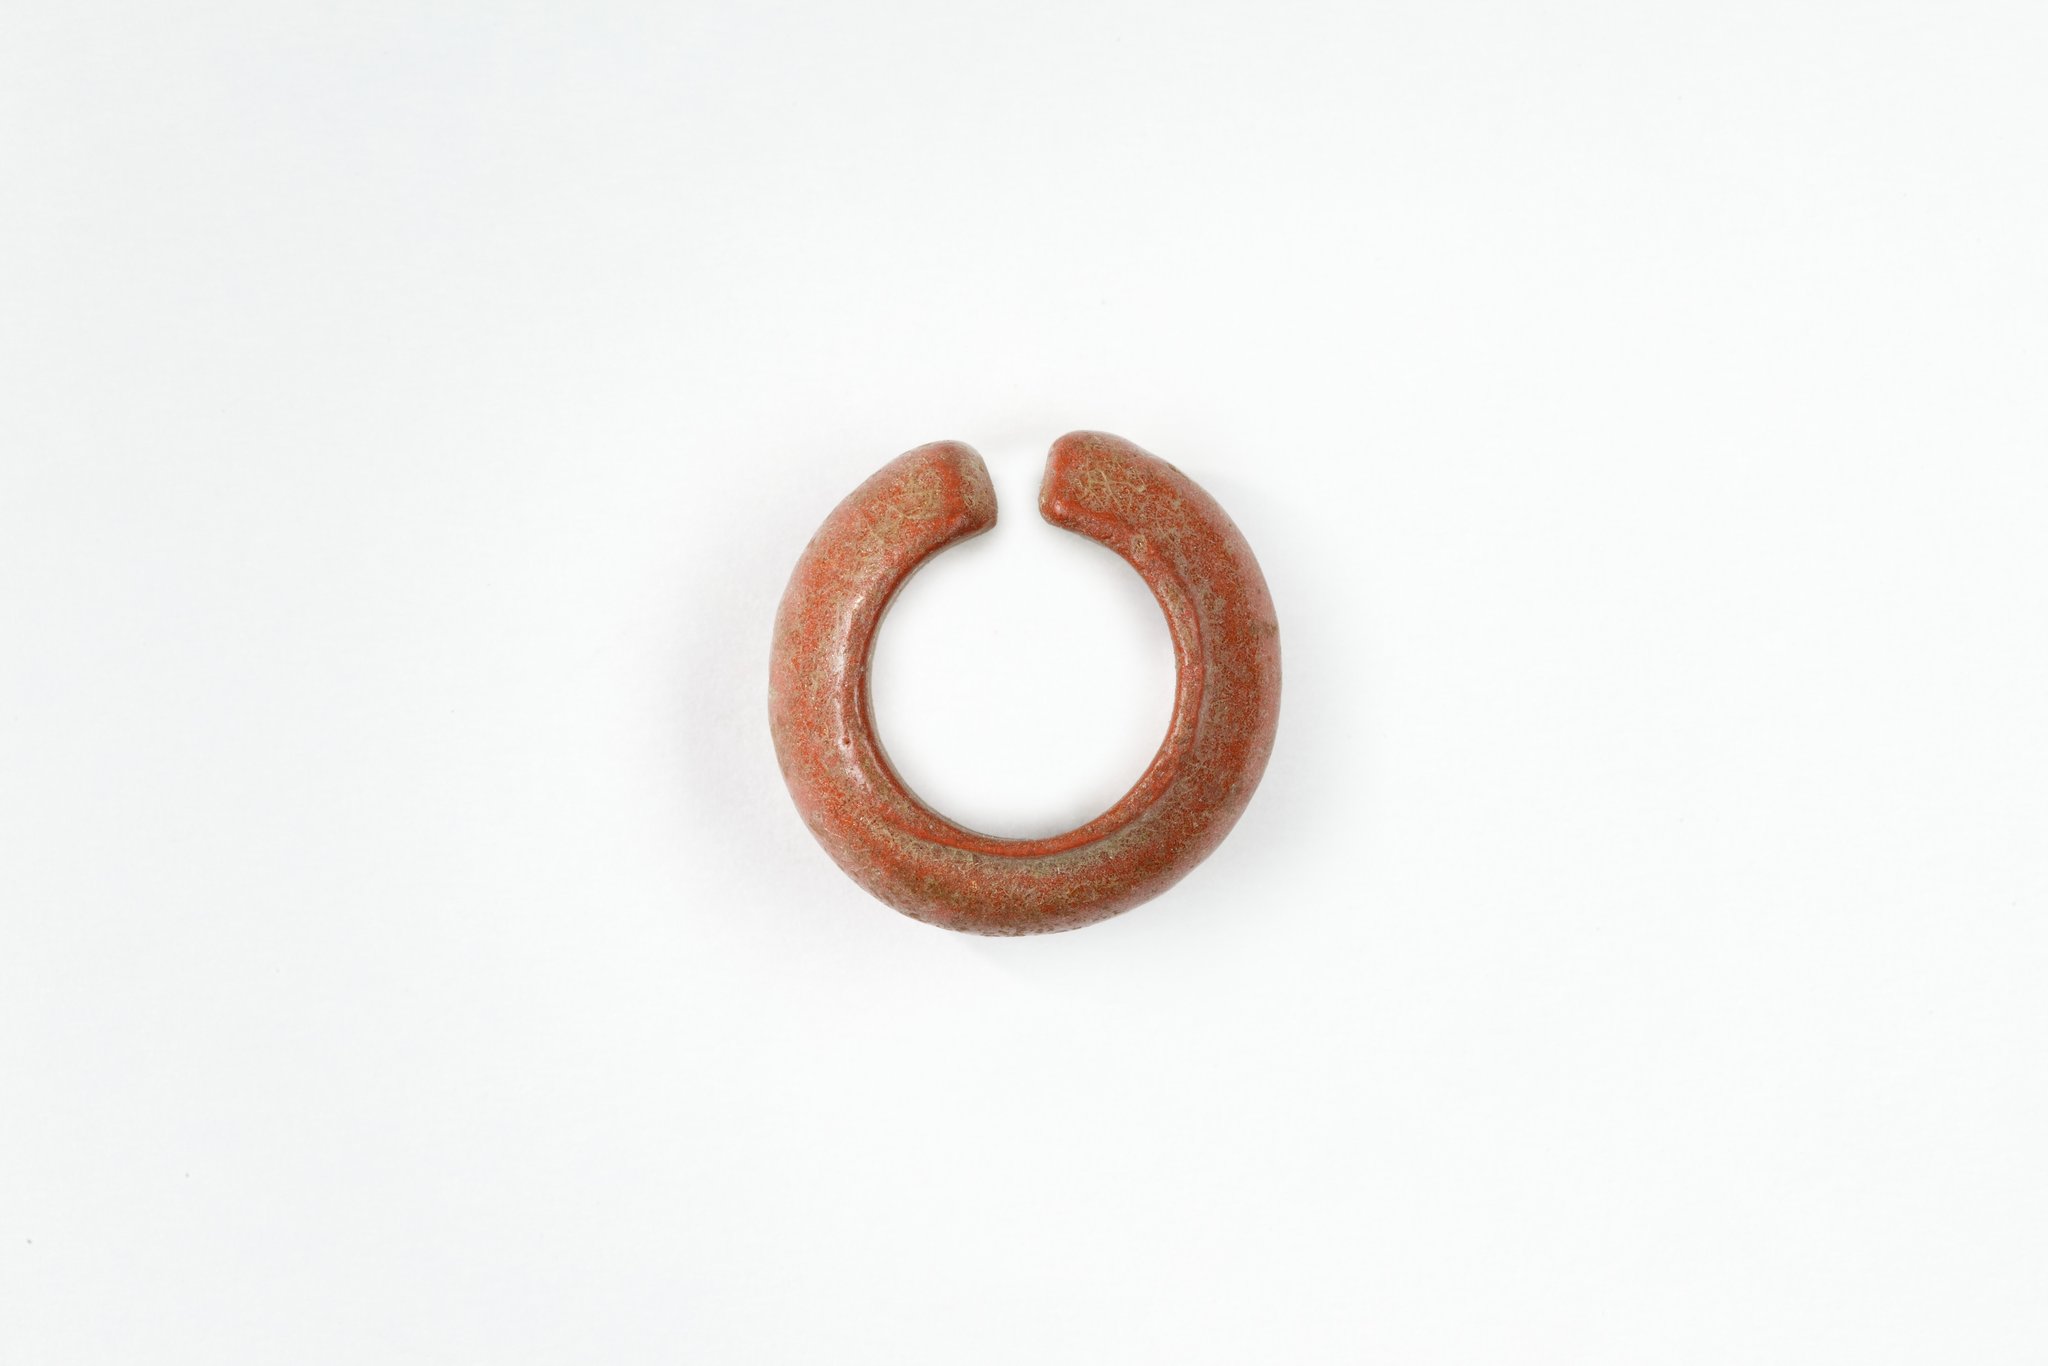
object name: earring, penannular, circular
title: Penannular Earring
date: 1550-1295 BCE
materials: faience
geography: northern upper egypt